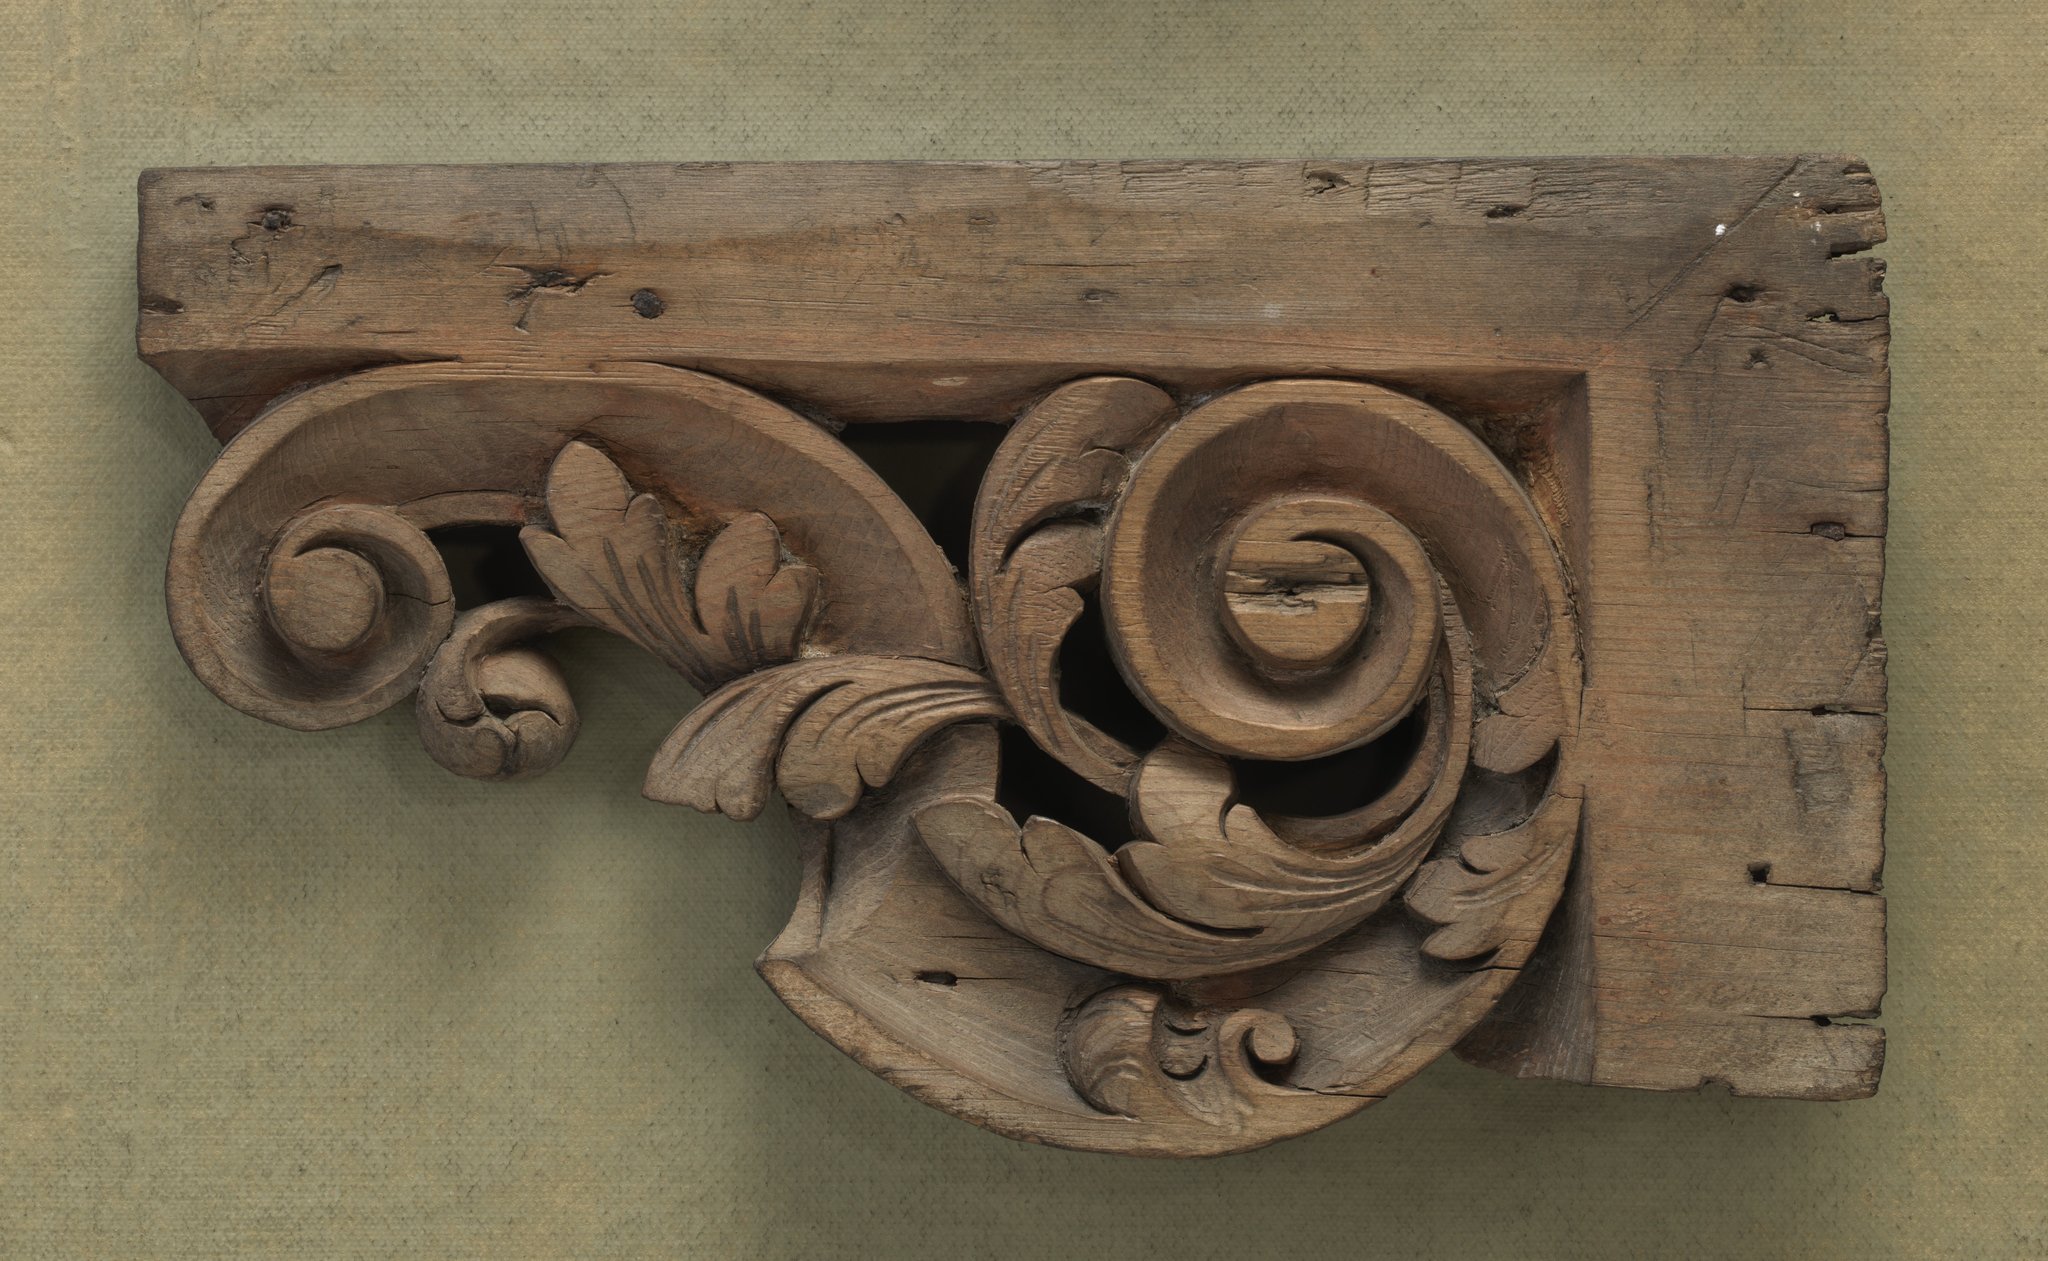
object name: bracket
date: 1701-1800